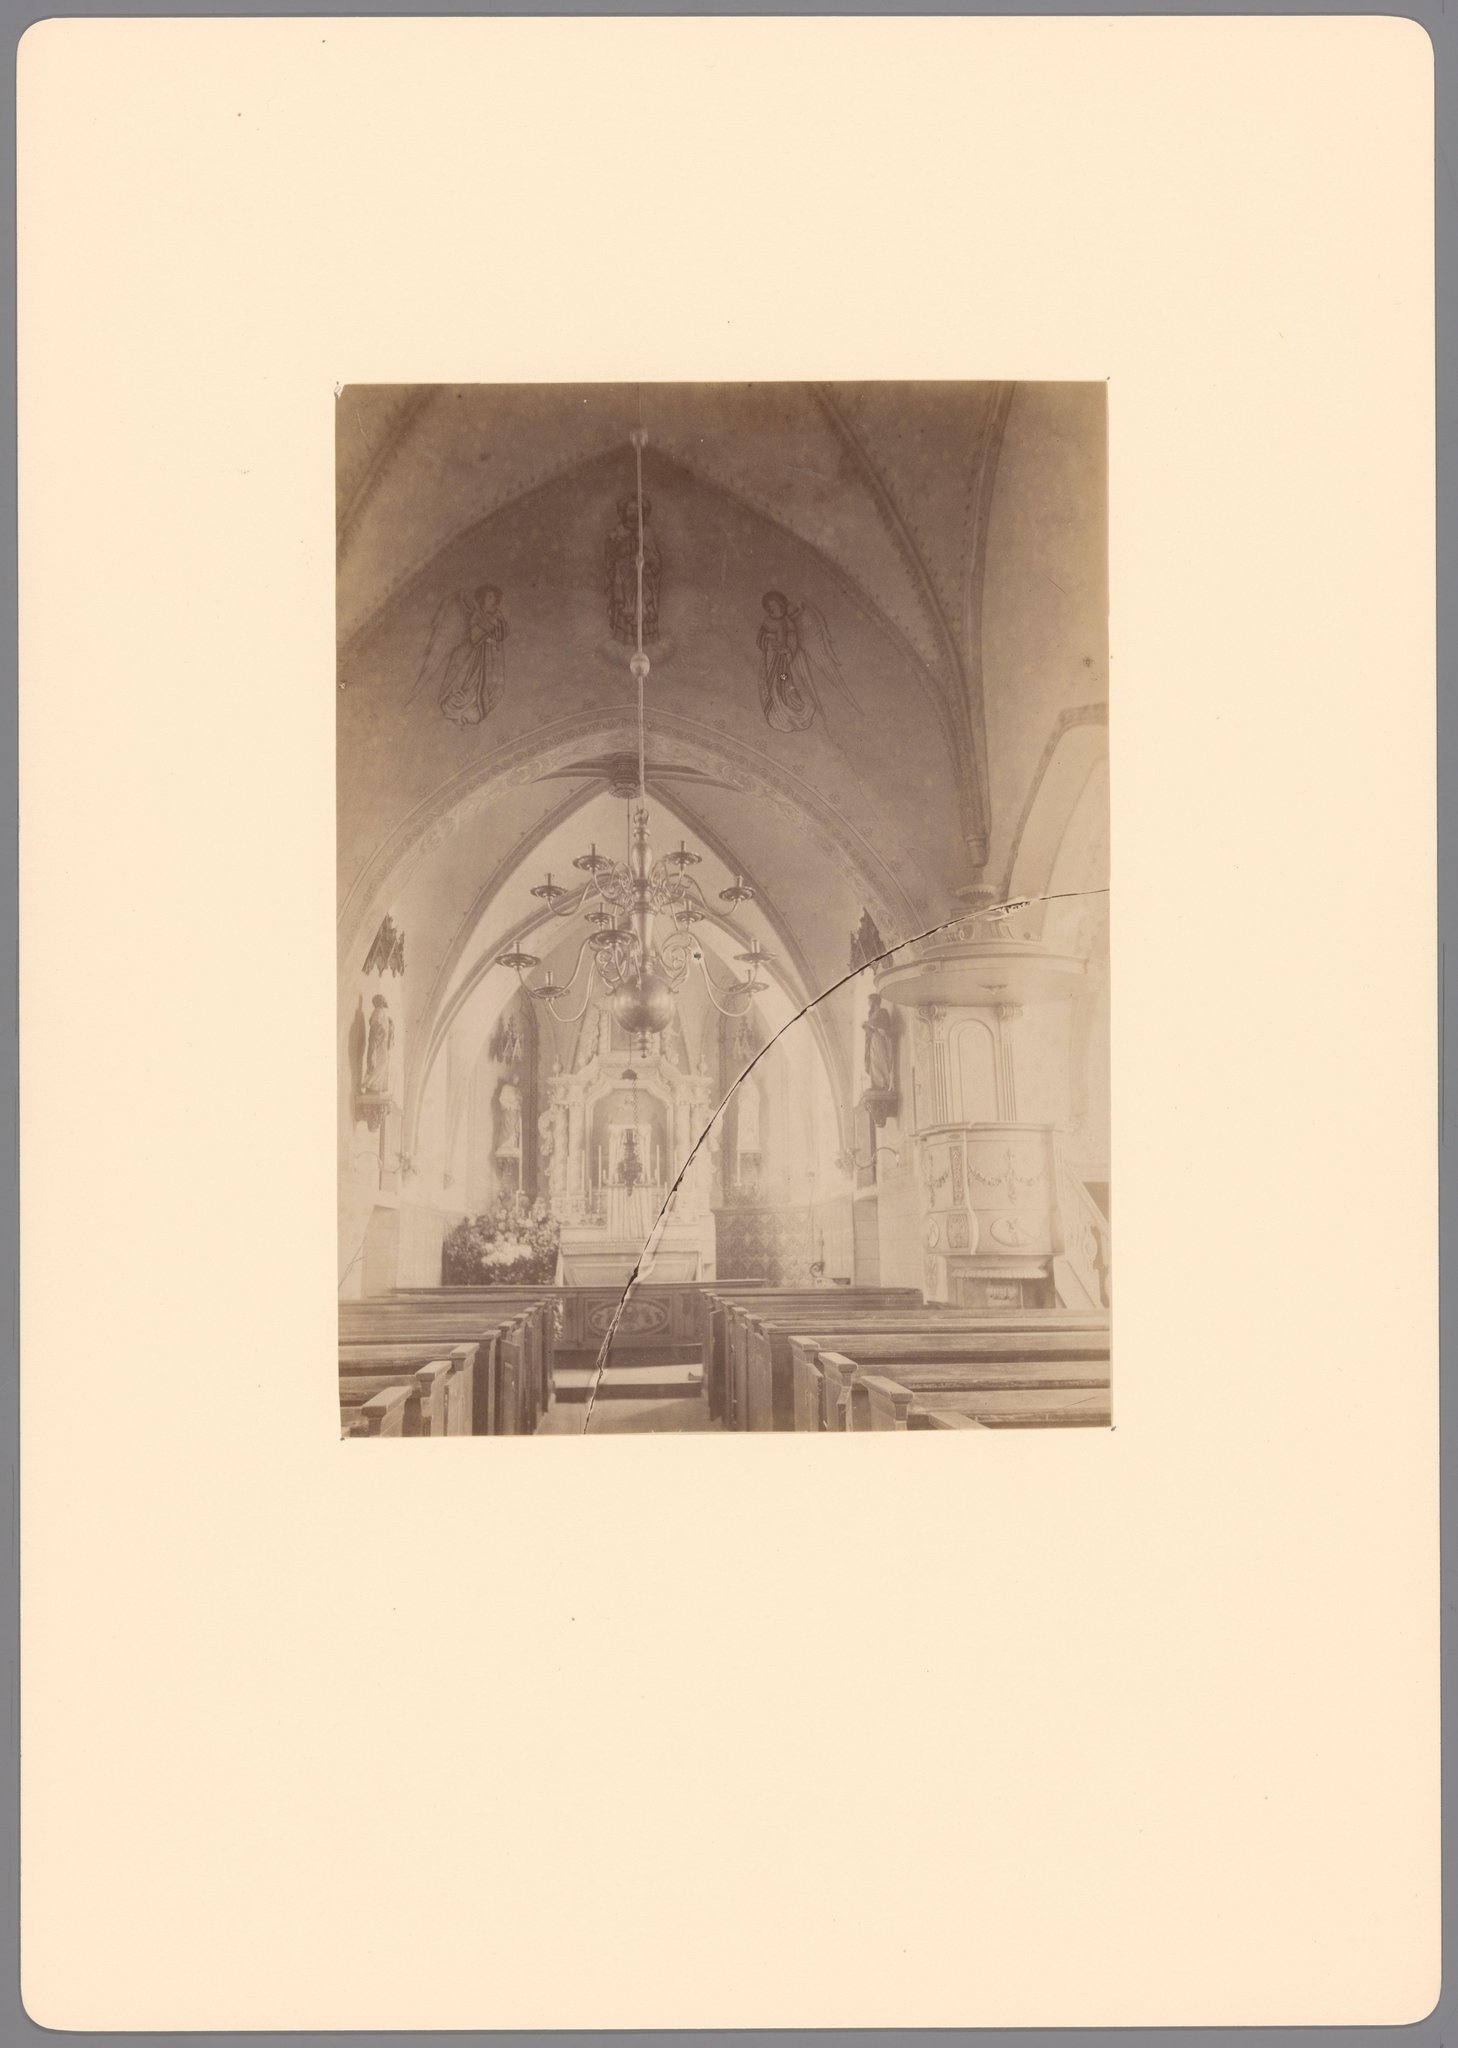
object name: photograph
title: Interieur van de Remigiuskerk te Duiven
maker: anoniem (monumentenzorg)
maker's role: fotograaf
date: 1905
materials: cardboard, photographic support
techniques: albumen print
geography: duiven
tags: interior of church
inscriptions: annotation: ‘Duiven (G.)/ R.K. Kerk’